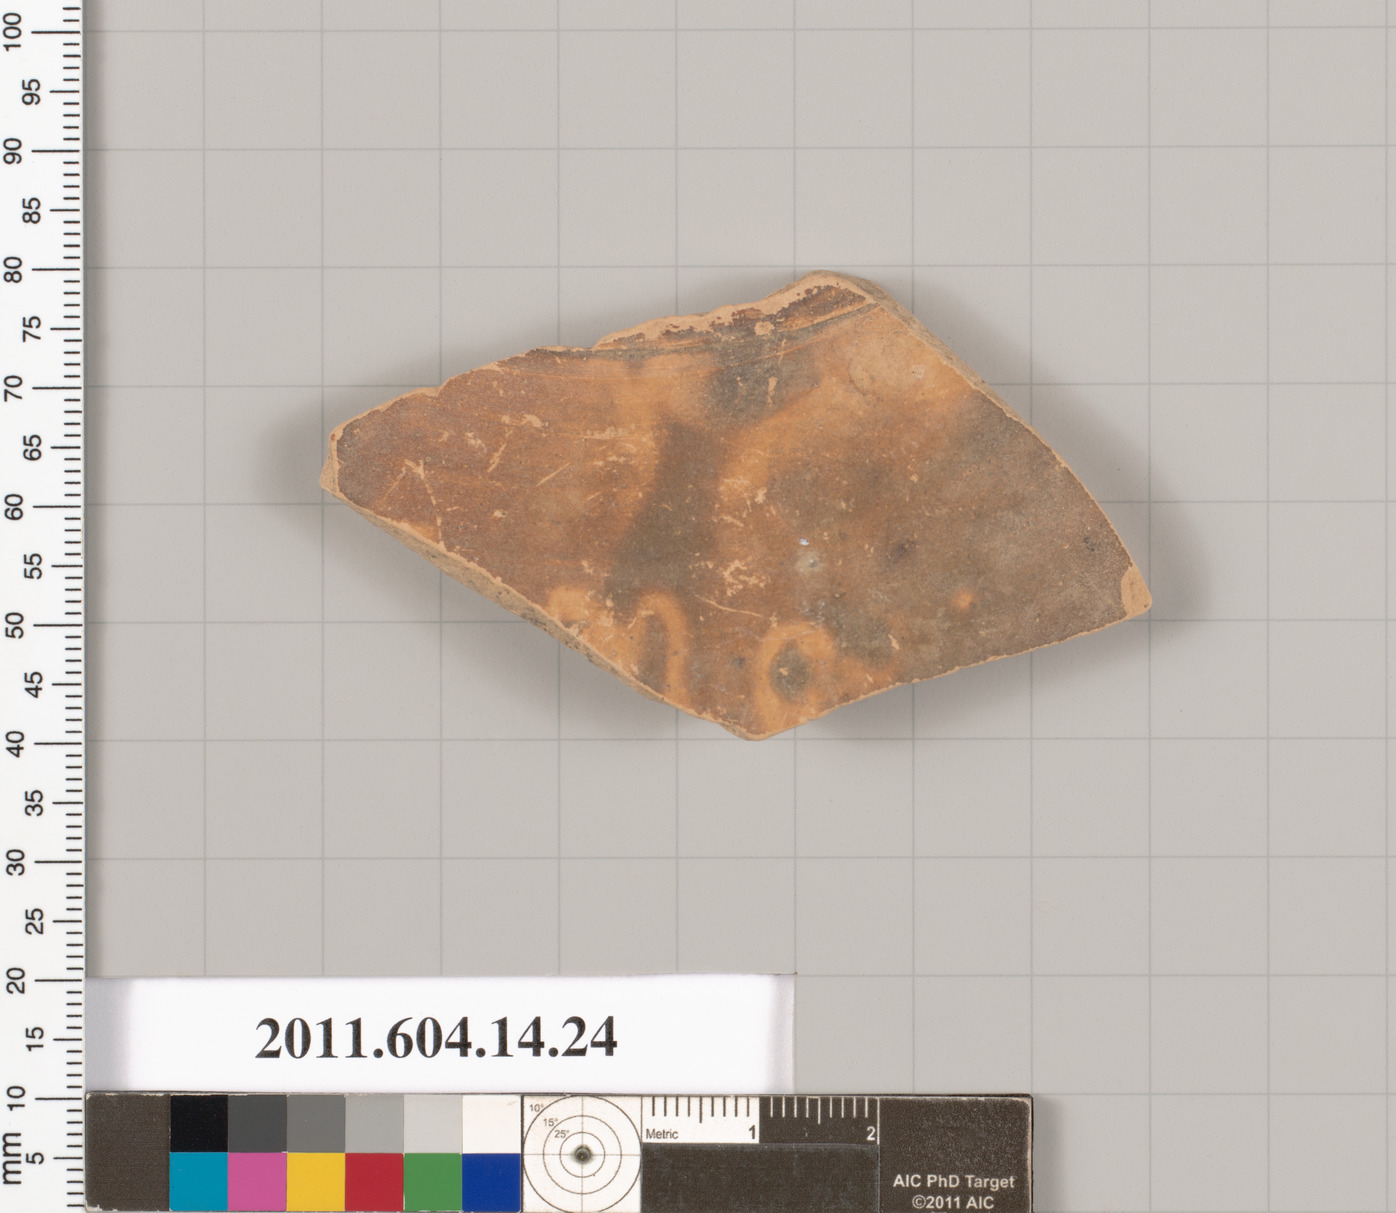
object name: undetermined closed shape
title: Terracotta fragment of an undetermined closed shape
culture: unknown fabric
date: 600-501 BCE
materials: terracotta